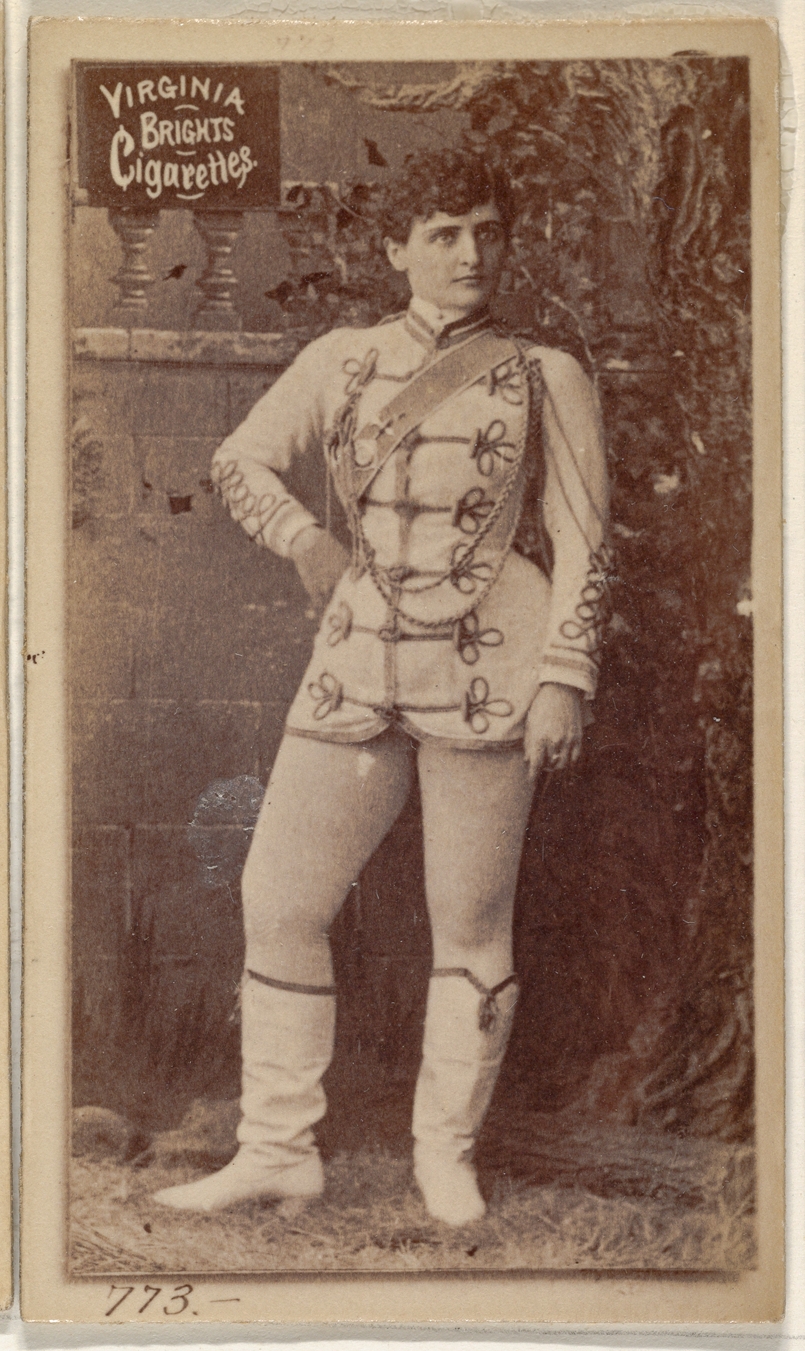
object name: photograph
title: Card 773, from the Actors and Actresses series (N45, Type 2) for Virginia Brights Cigarettes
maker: allen & ginter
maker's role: publisher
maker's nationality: american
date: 1888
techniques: albumen silver print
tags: portraits,women,actresses